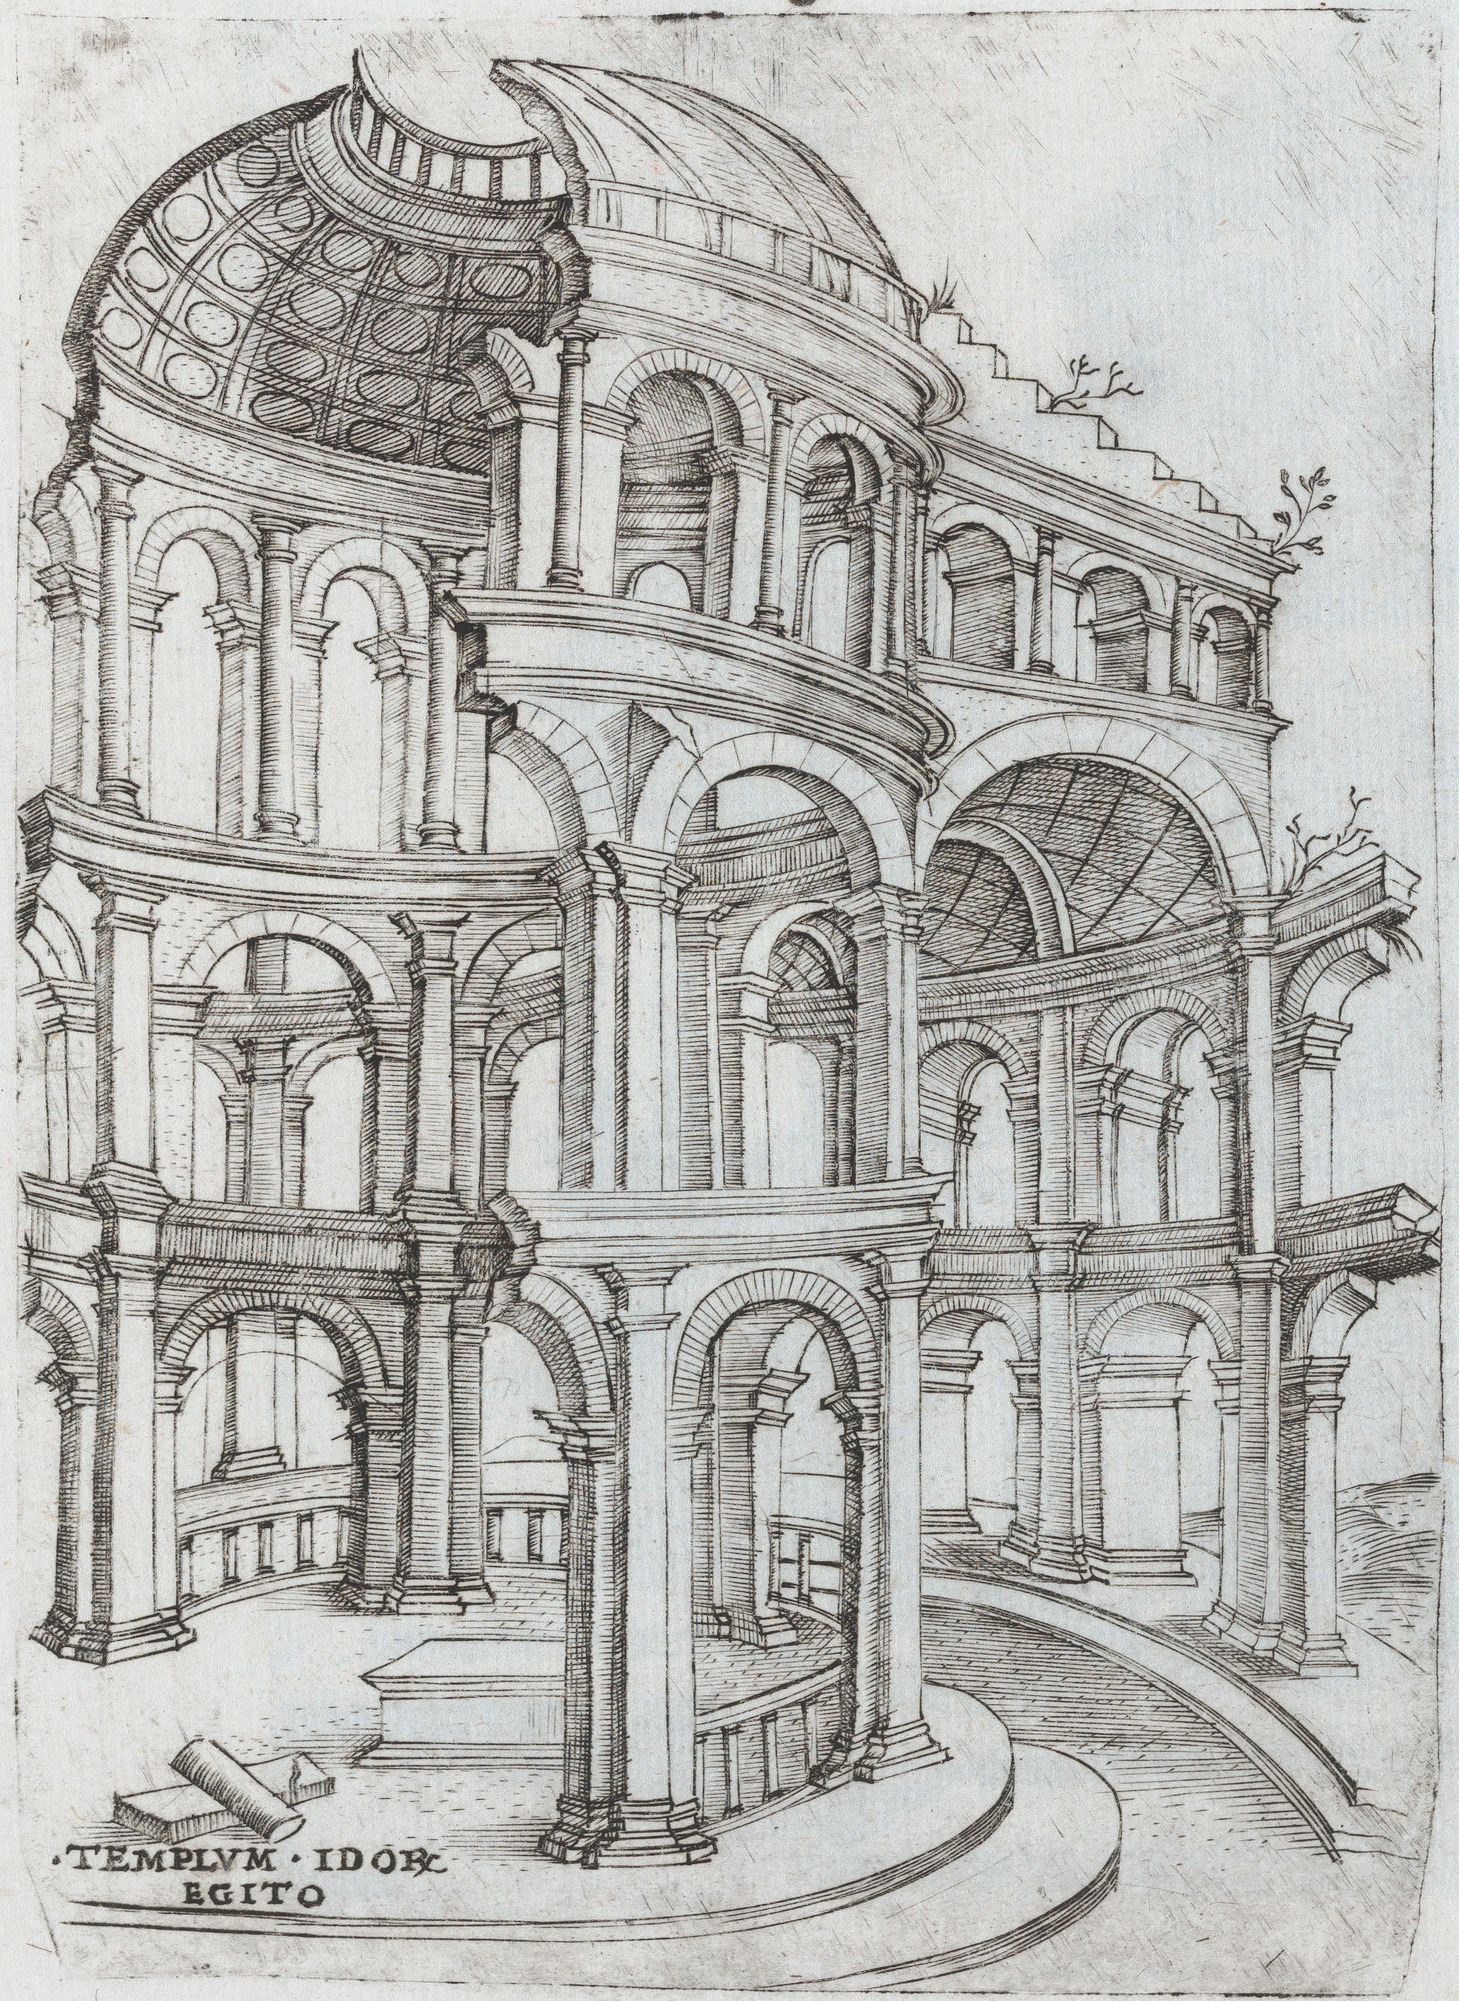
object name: album print ornament architecture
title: Templum Isaiae Prophetae, from a Series of Prints depicting (reconstructed) Buildings from Roman Antiquity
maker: monogrammist g.a. with the caltrop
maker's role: artist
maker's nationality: italian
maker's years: 1535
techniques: engraving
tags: temples,ruins